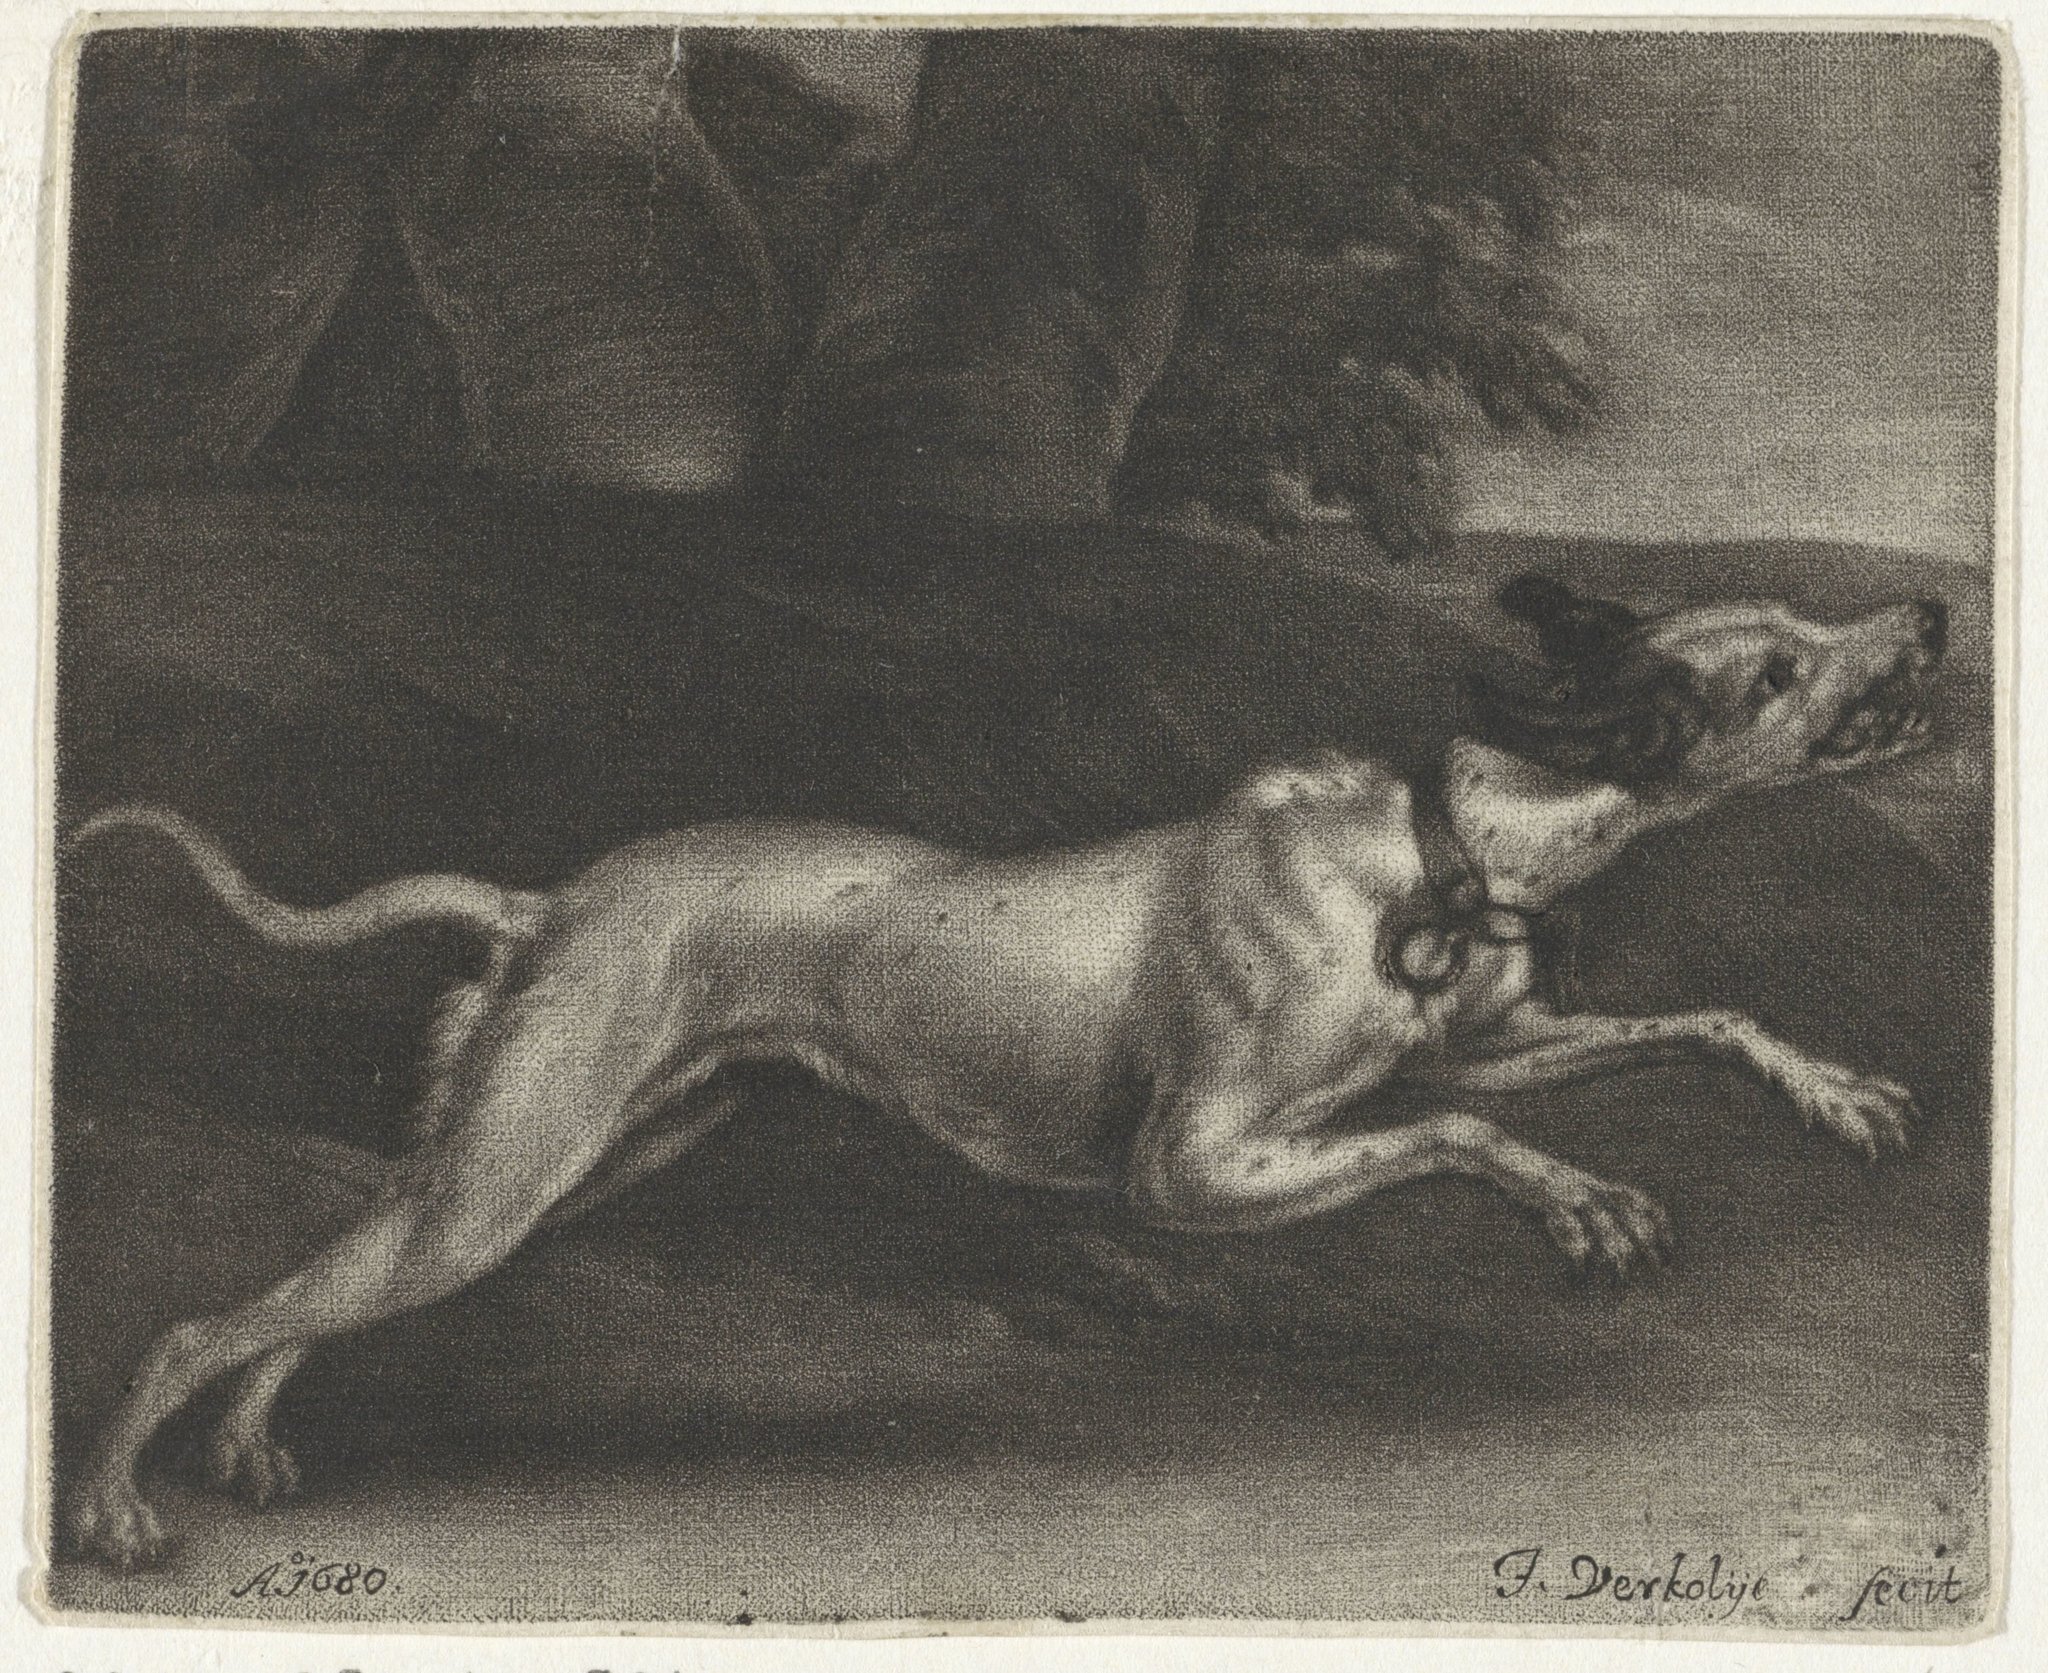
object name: print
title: Rennende hond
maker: jan verkolje (i)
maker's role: draughtsman, painter, print maker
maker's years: 1650-1693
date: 1680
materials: paper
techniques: mezzotint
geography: delft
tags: dog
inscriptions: collector's mark: Lugt 2228